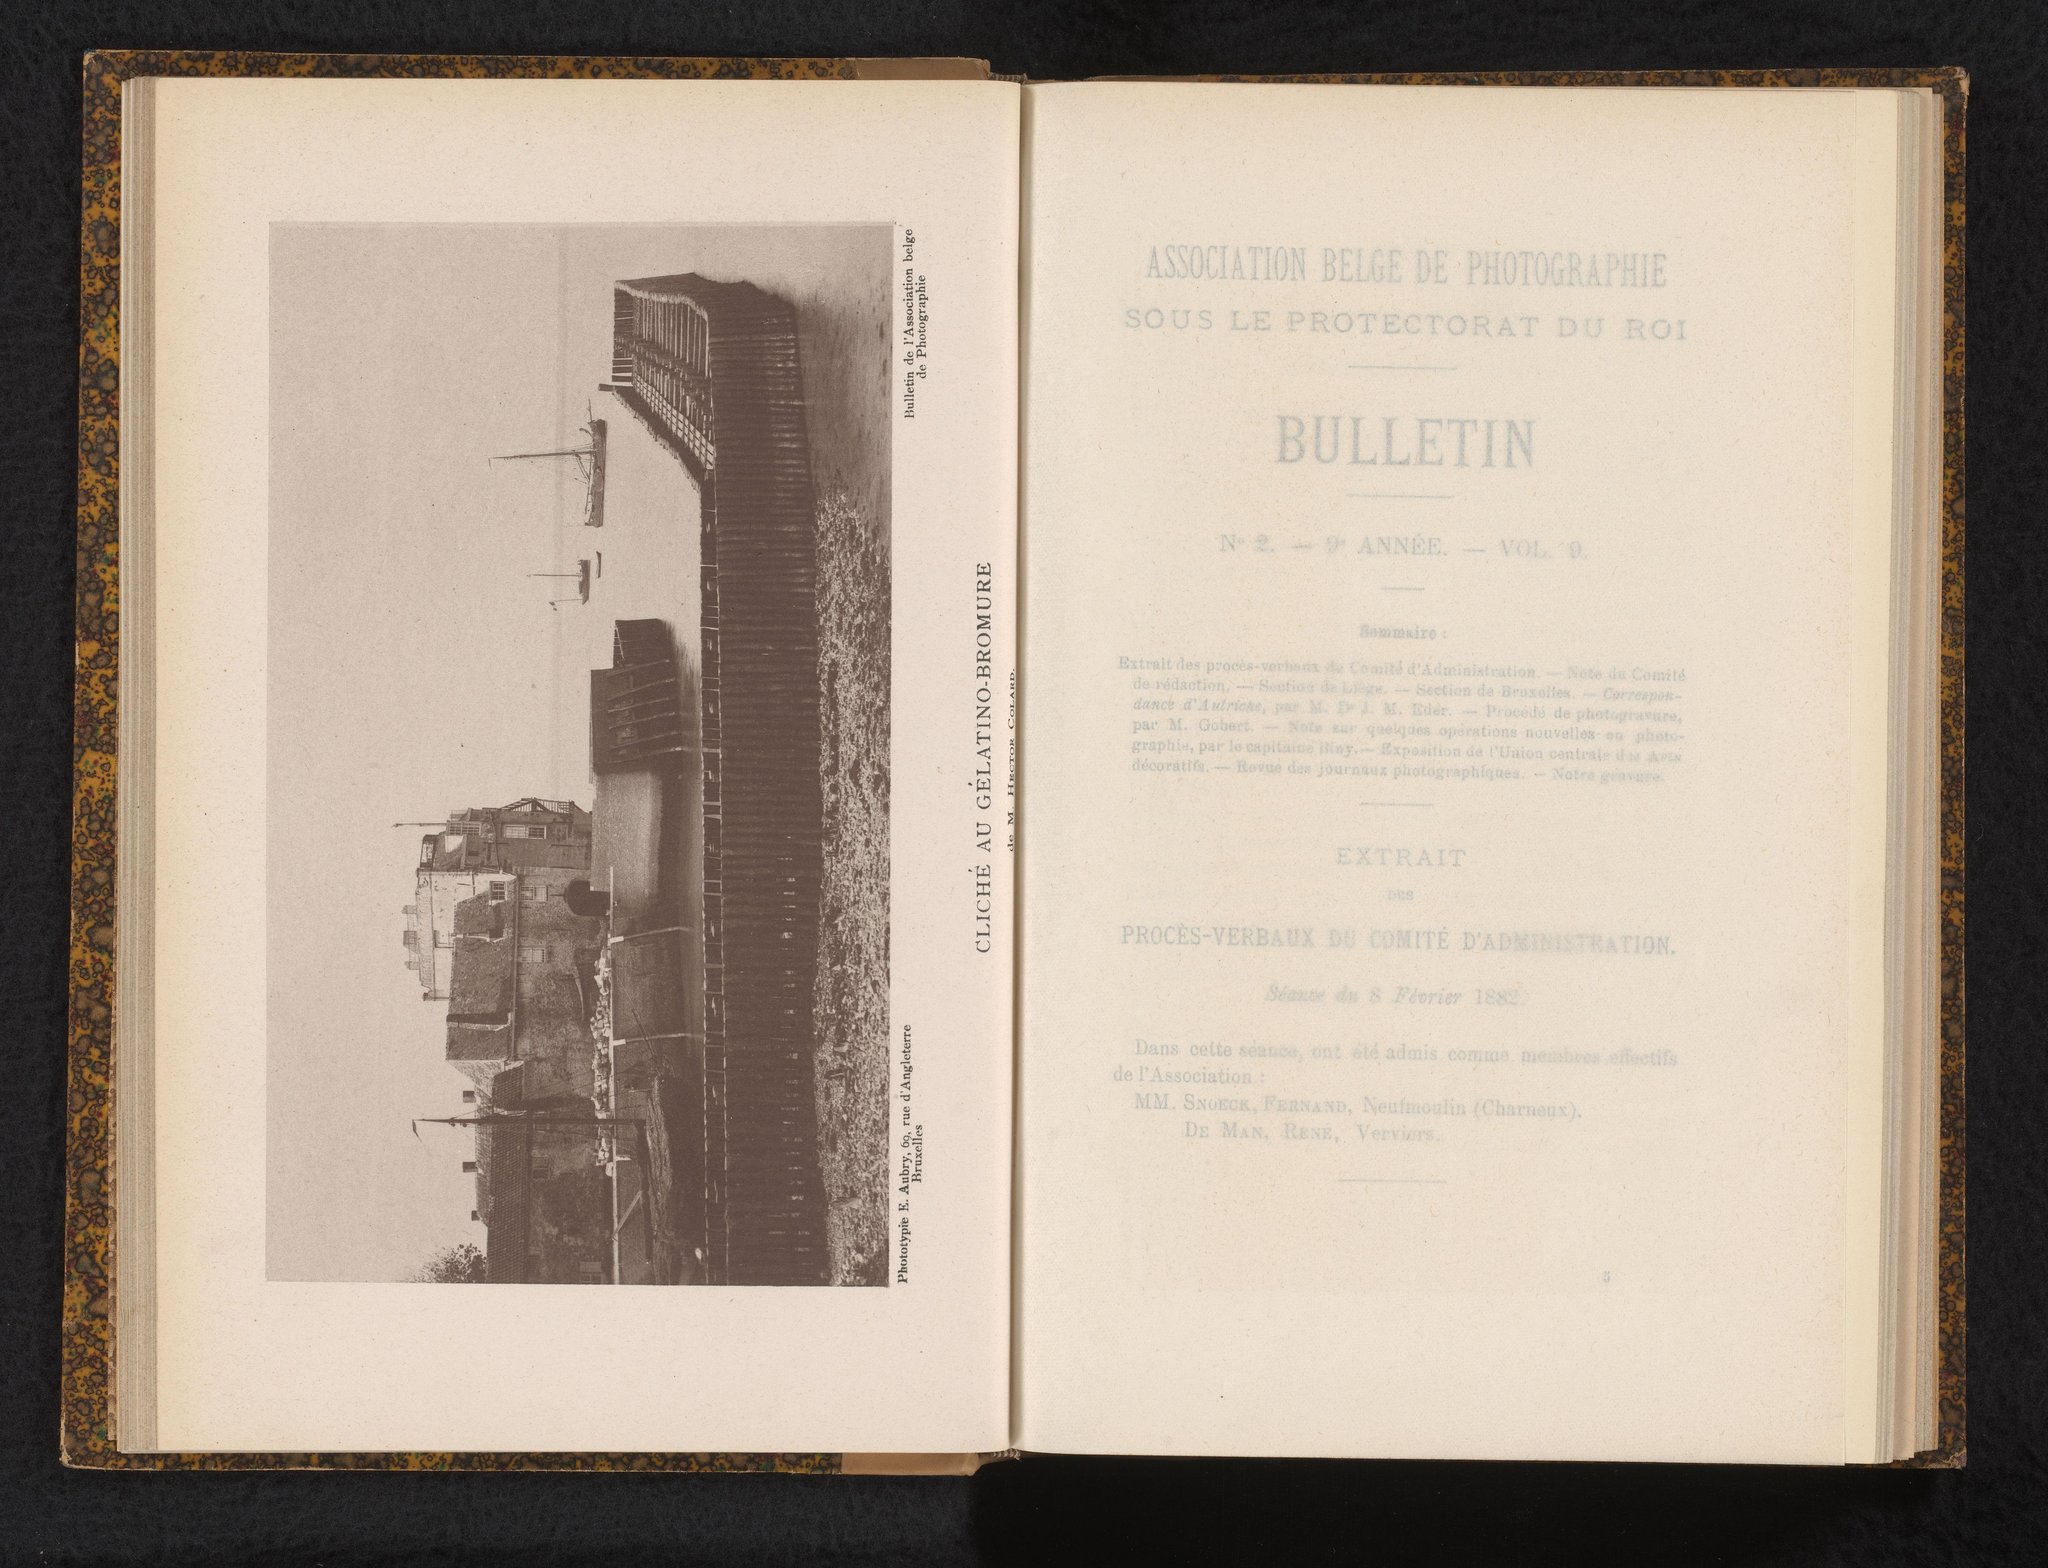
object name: photomechanical print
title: Kade met borstwering en huizen aan zee, Veere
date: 1877-1882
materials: paper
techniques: photograph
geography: brussels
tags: urban housing, sea (seascape), coastal protection work, breakwater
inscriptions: inscription: ‘Cliché au gélatino-bromure’